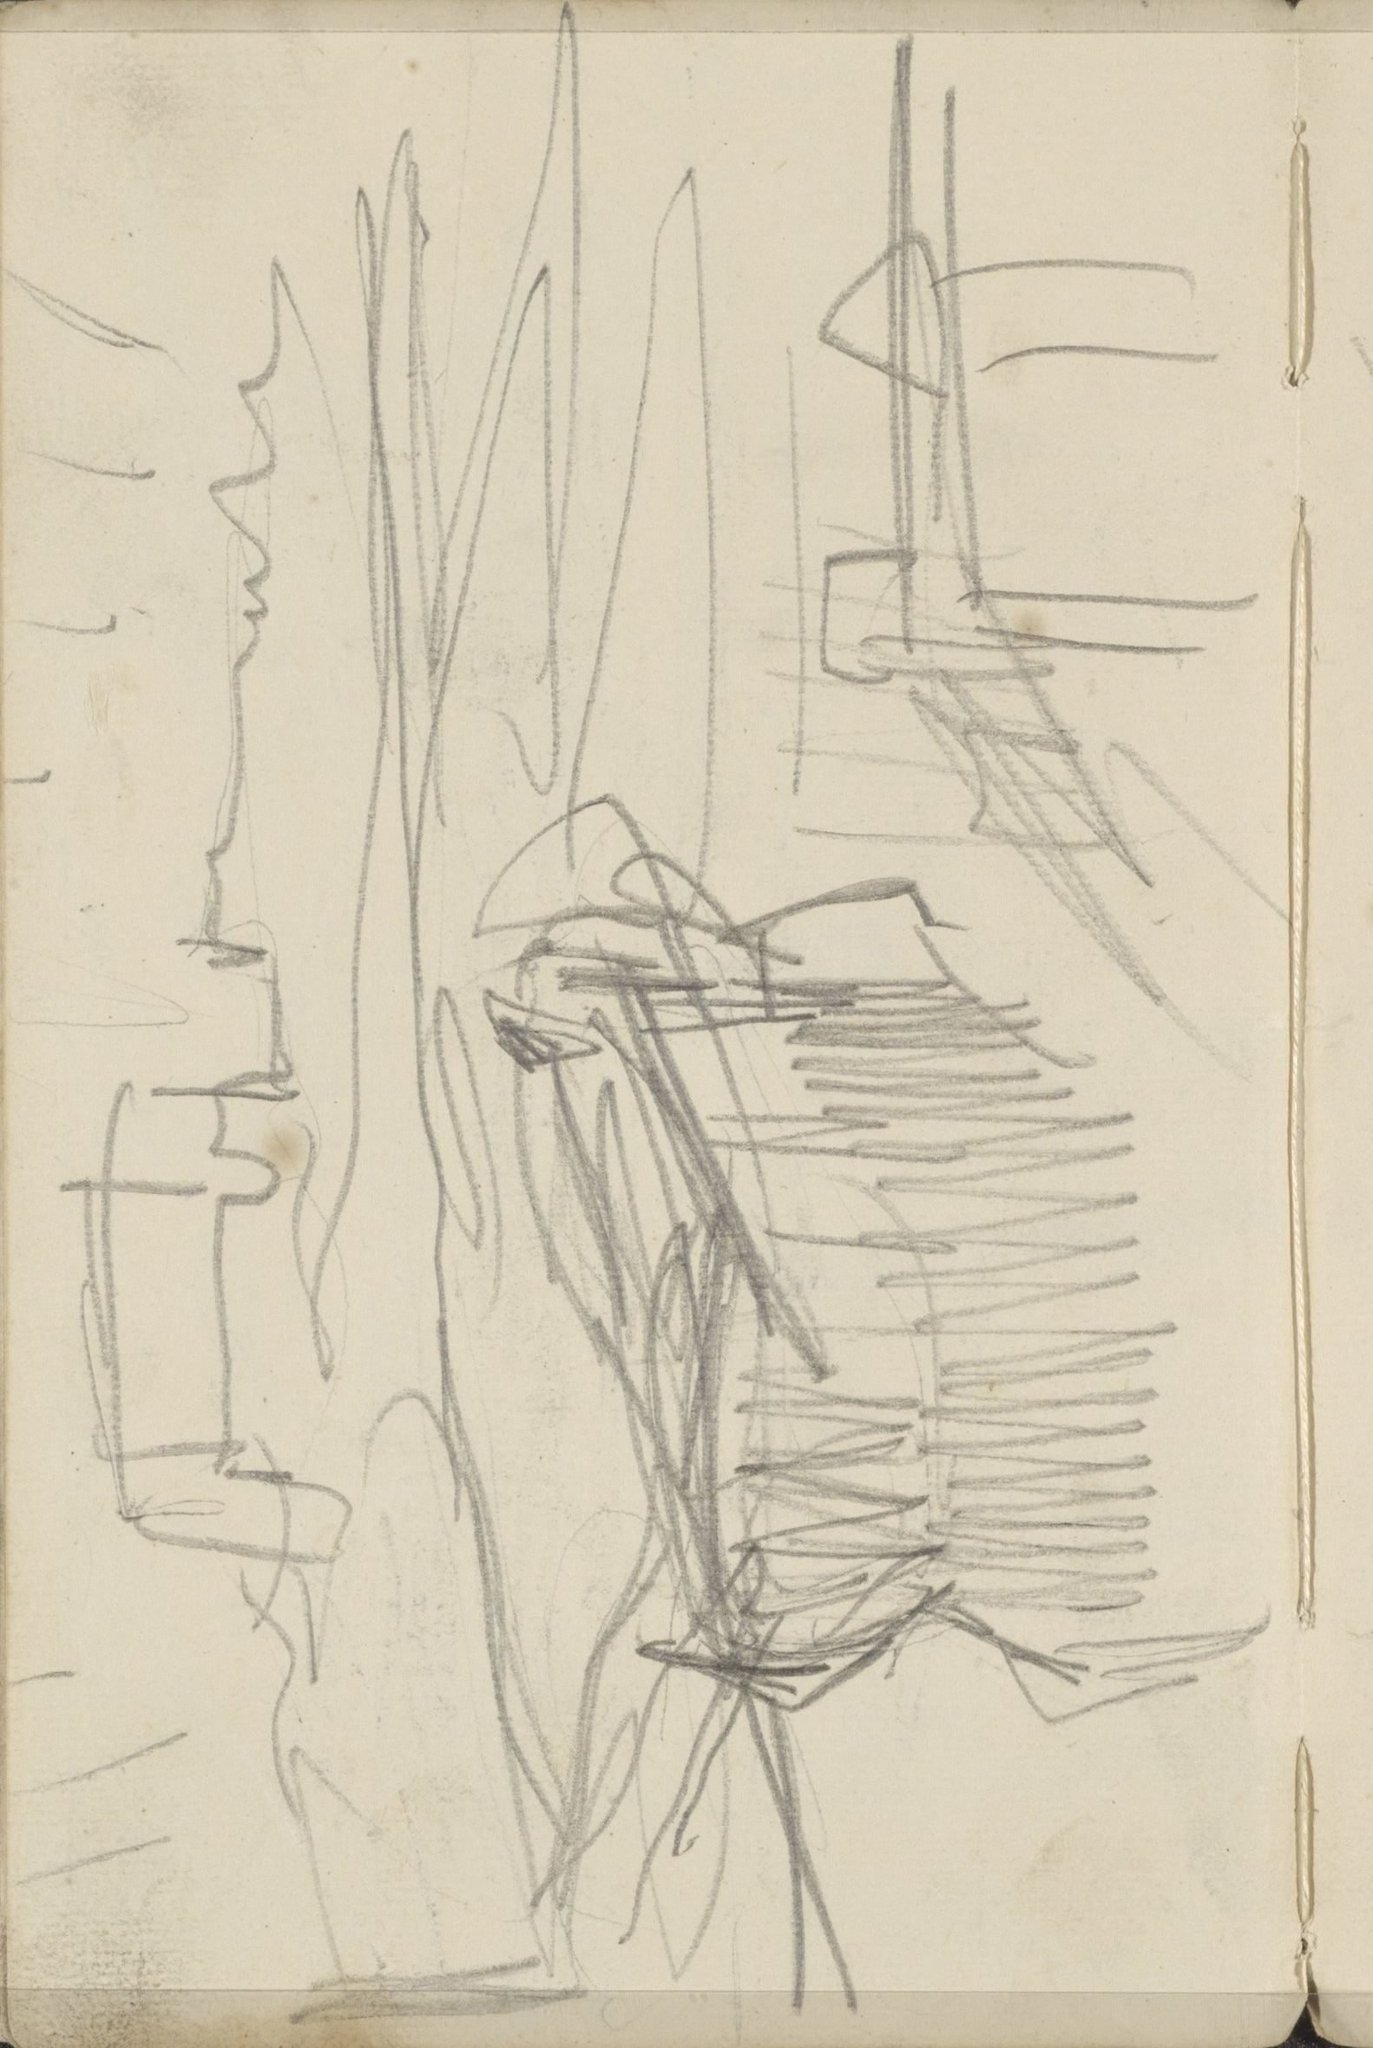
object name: sketchbook leaf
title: Aangemeerde boot, mogelijk een schuit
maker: george hendrik breitner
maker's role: draughtsman, painter, print maker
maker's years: 1857-1923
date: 1886-1923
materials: paper, pencil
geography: amsterdam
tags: ships (in general)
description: Pagina 7 uit een schetsboek met 14 bladen.